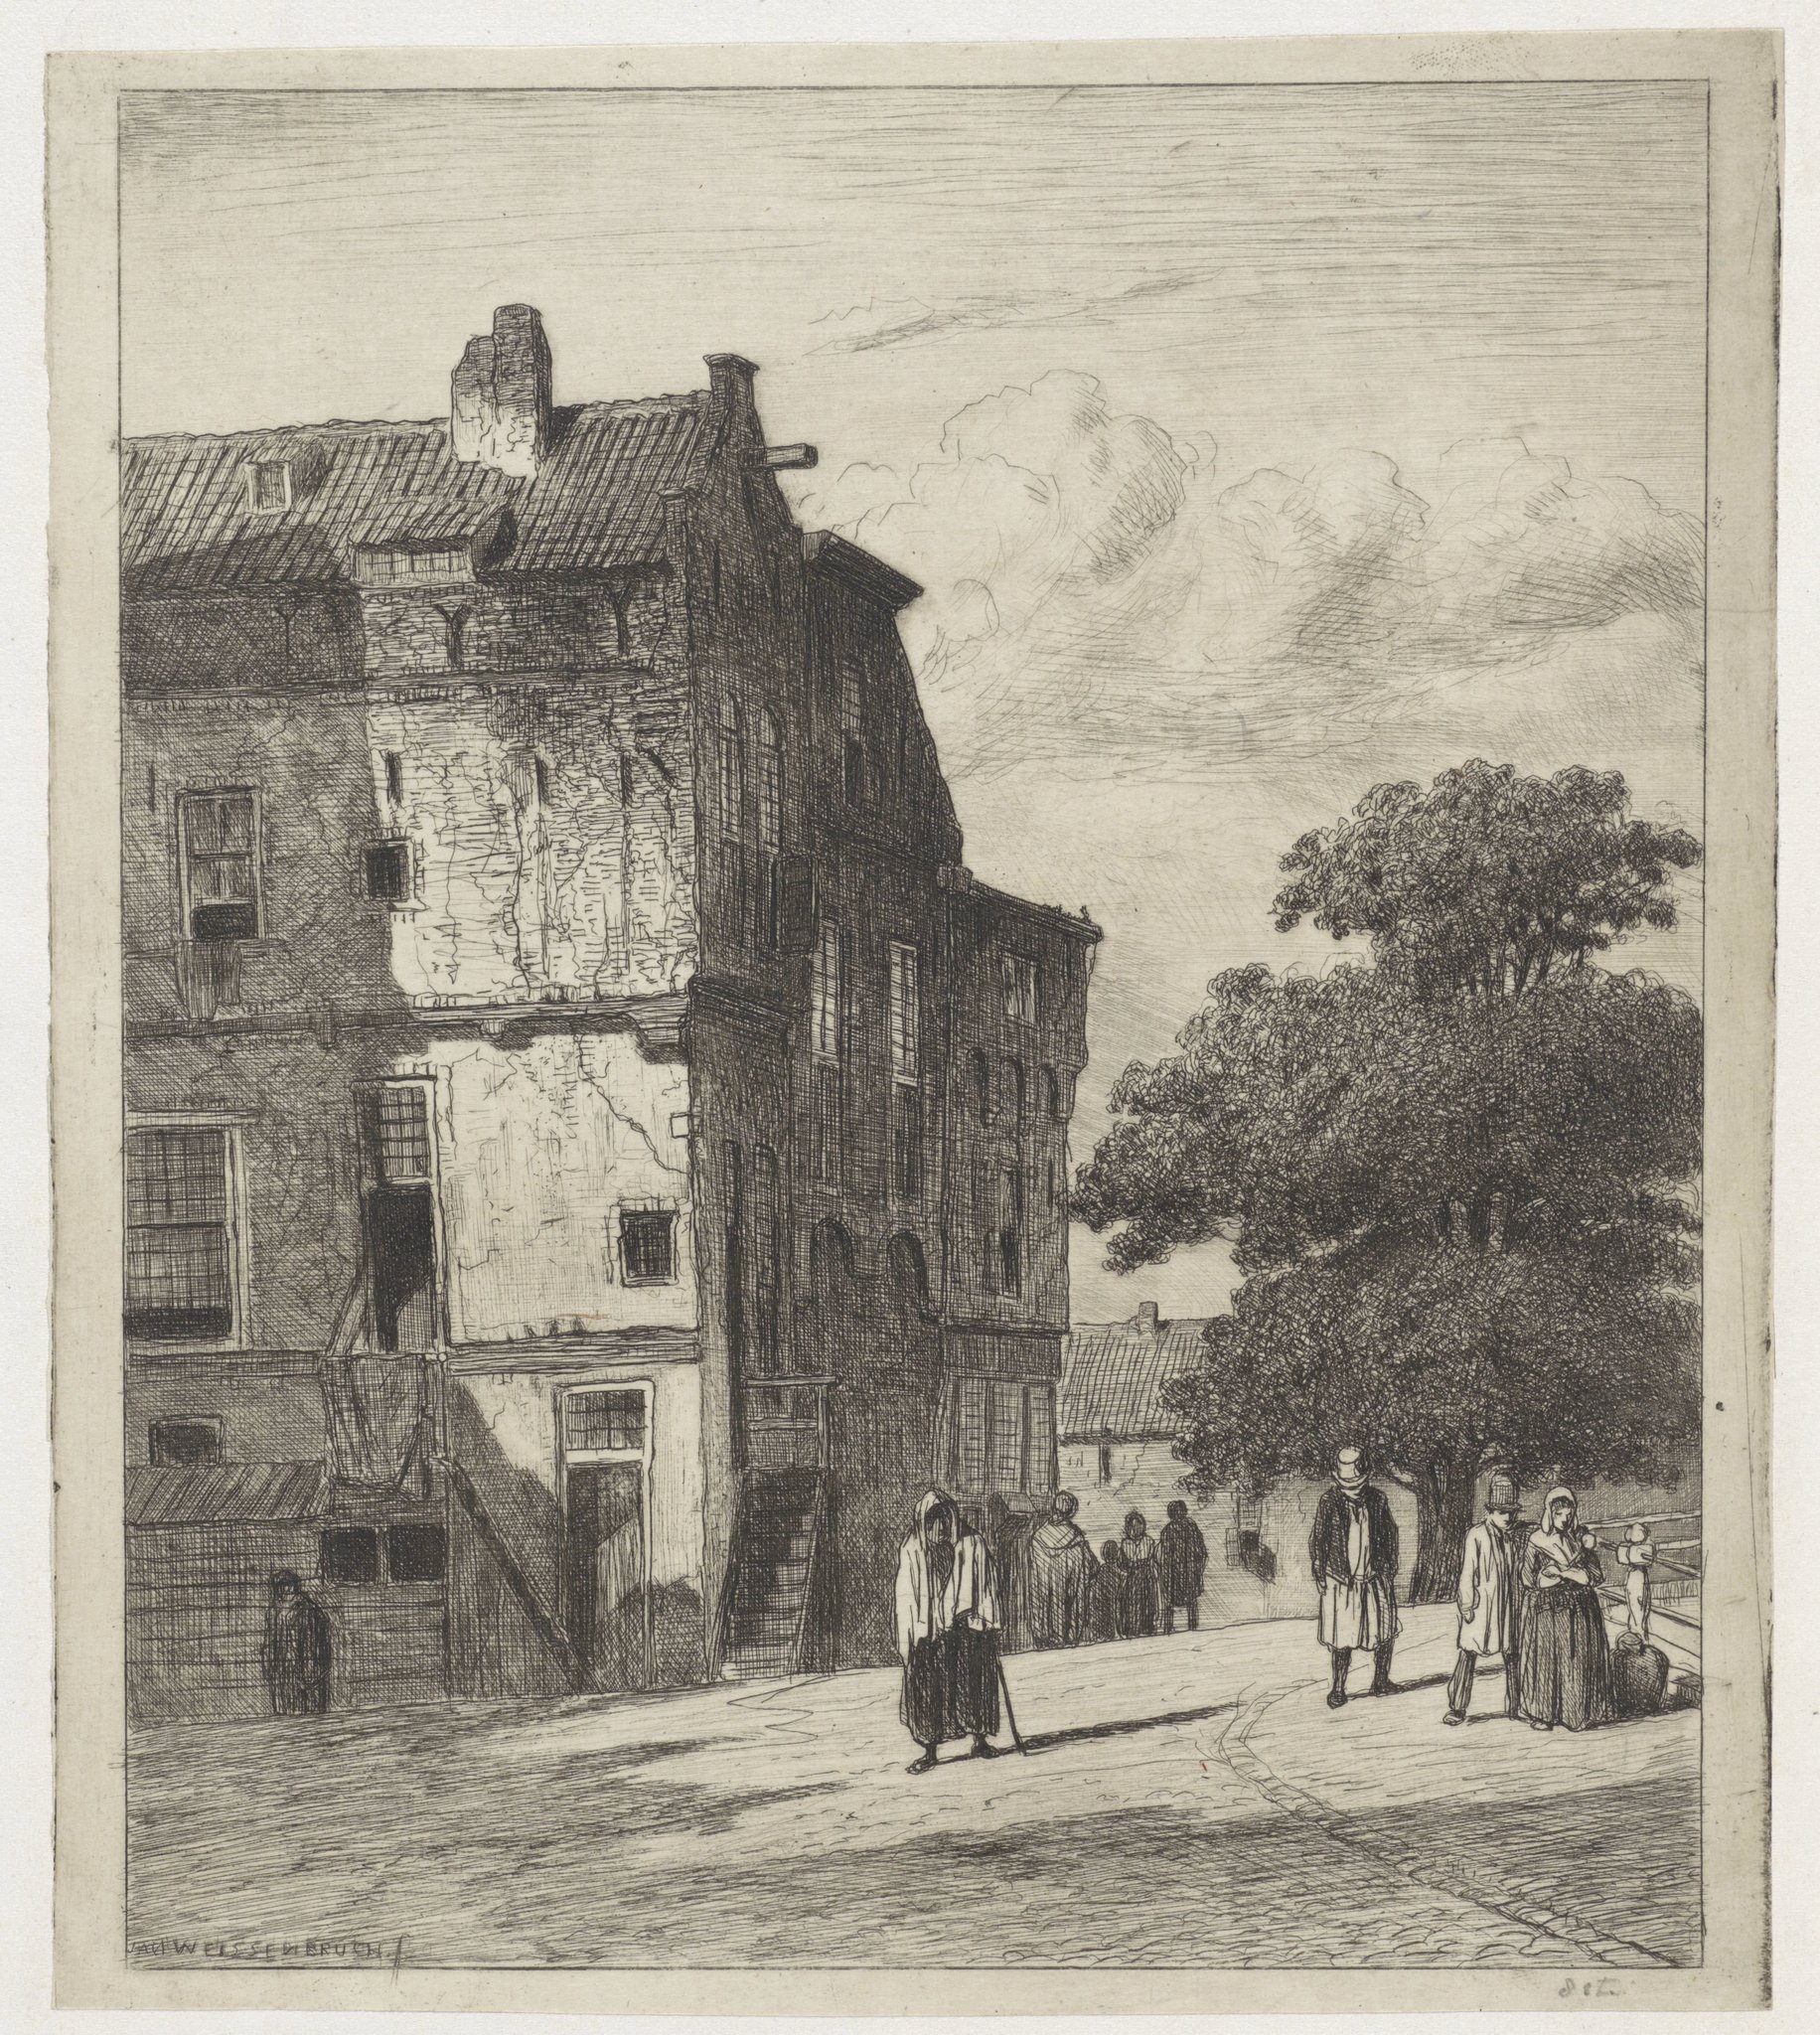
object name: print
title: Gezicht op een straat te Amsterdam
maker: jan weissenbruch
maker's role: painter, print maker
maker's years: 1822-1880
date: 1850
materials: paper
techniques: etching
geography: amsterdam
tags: urban housing, city-view, and landscape with man-made constructions, trees, adult woman, adult man, walking, amsterdam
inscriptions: date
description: Enkele figuren lopen over straat. Links en in de verte staan een paar huizen. Rechts zijn bomen te zien.